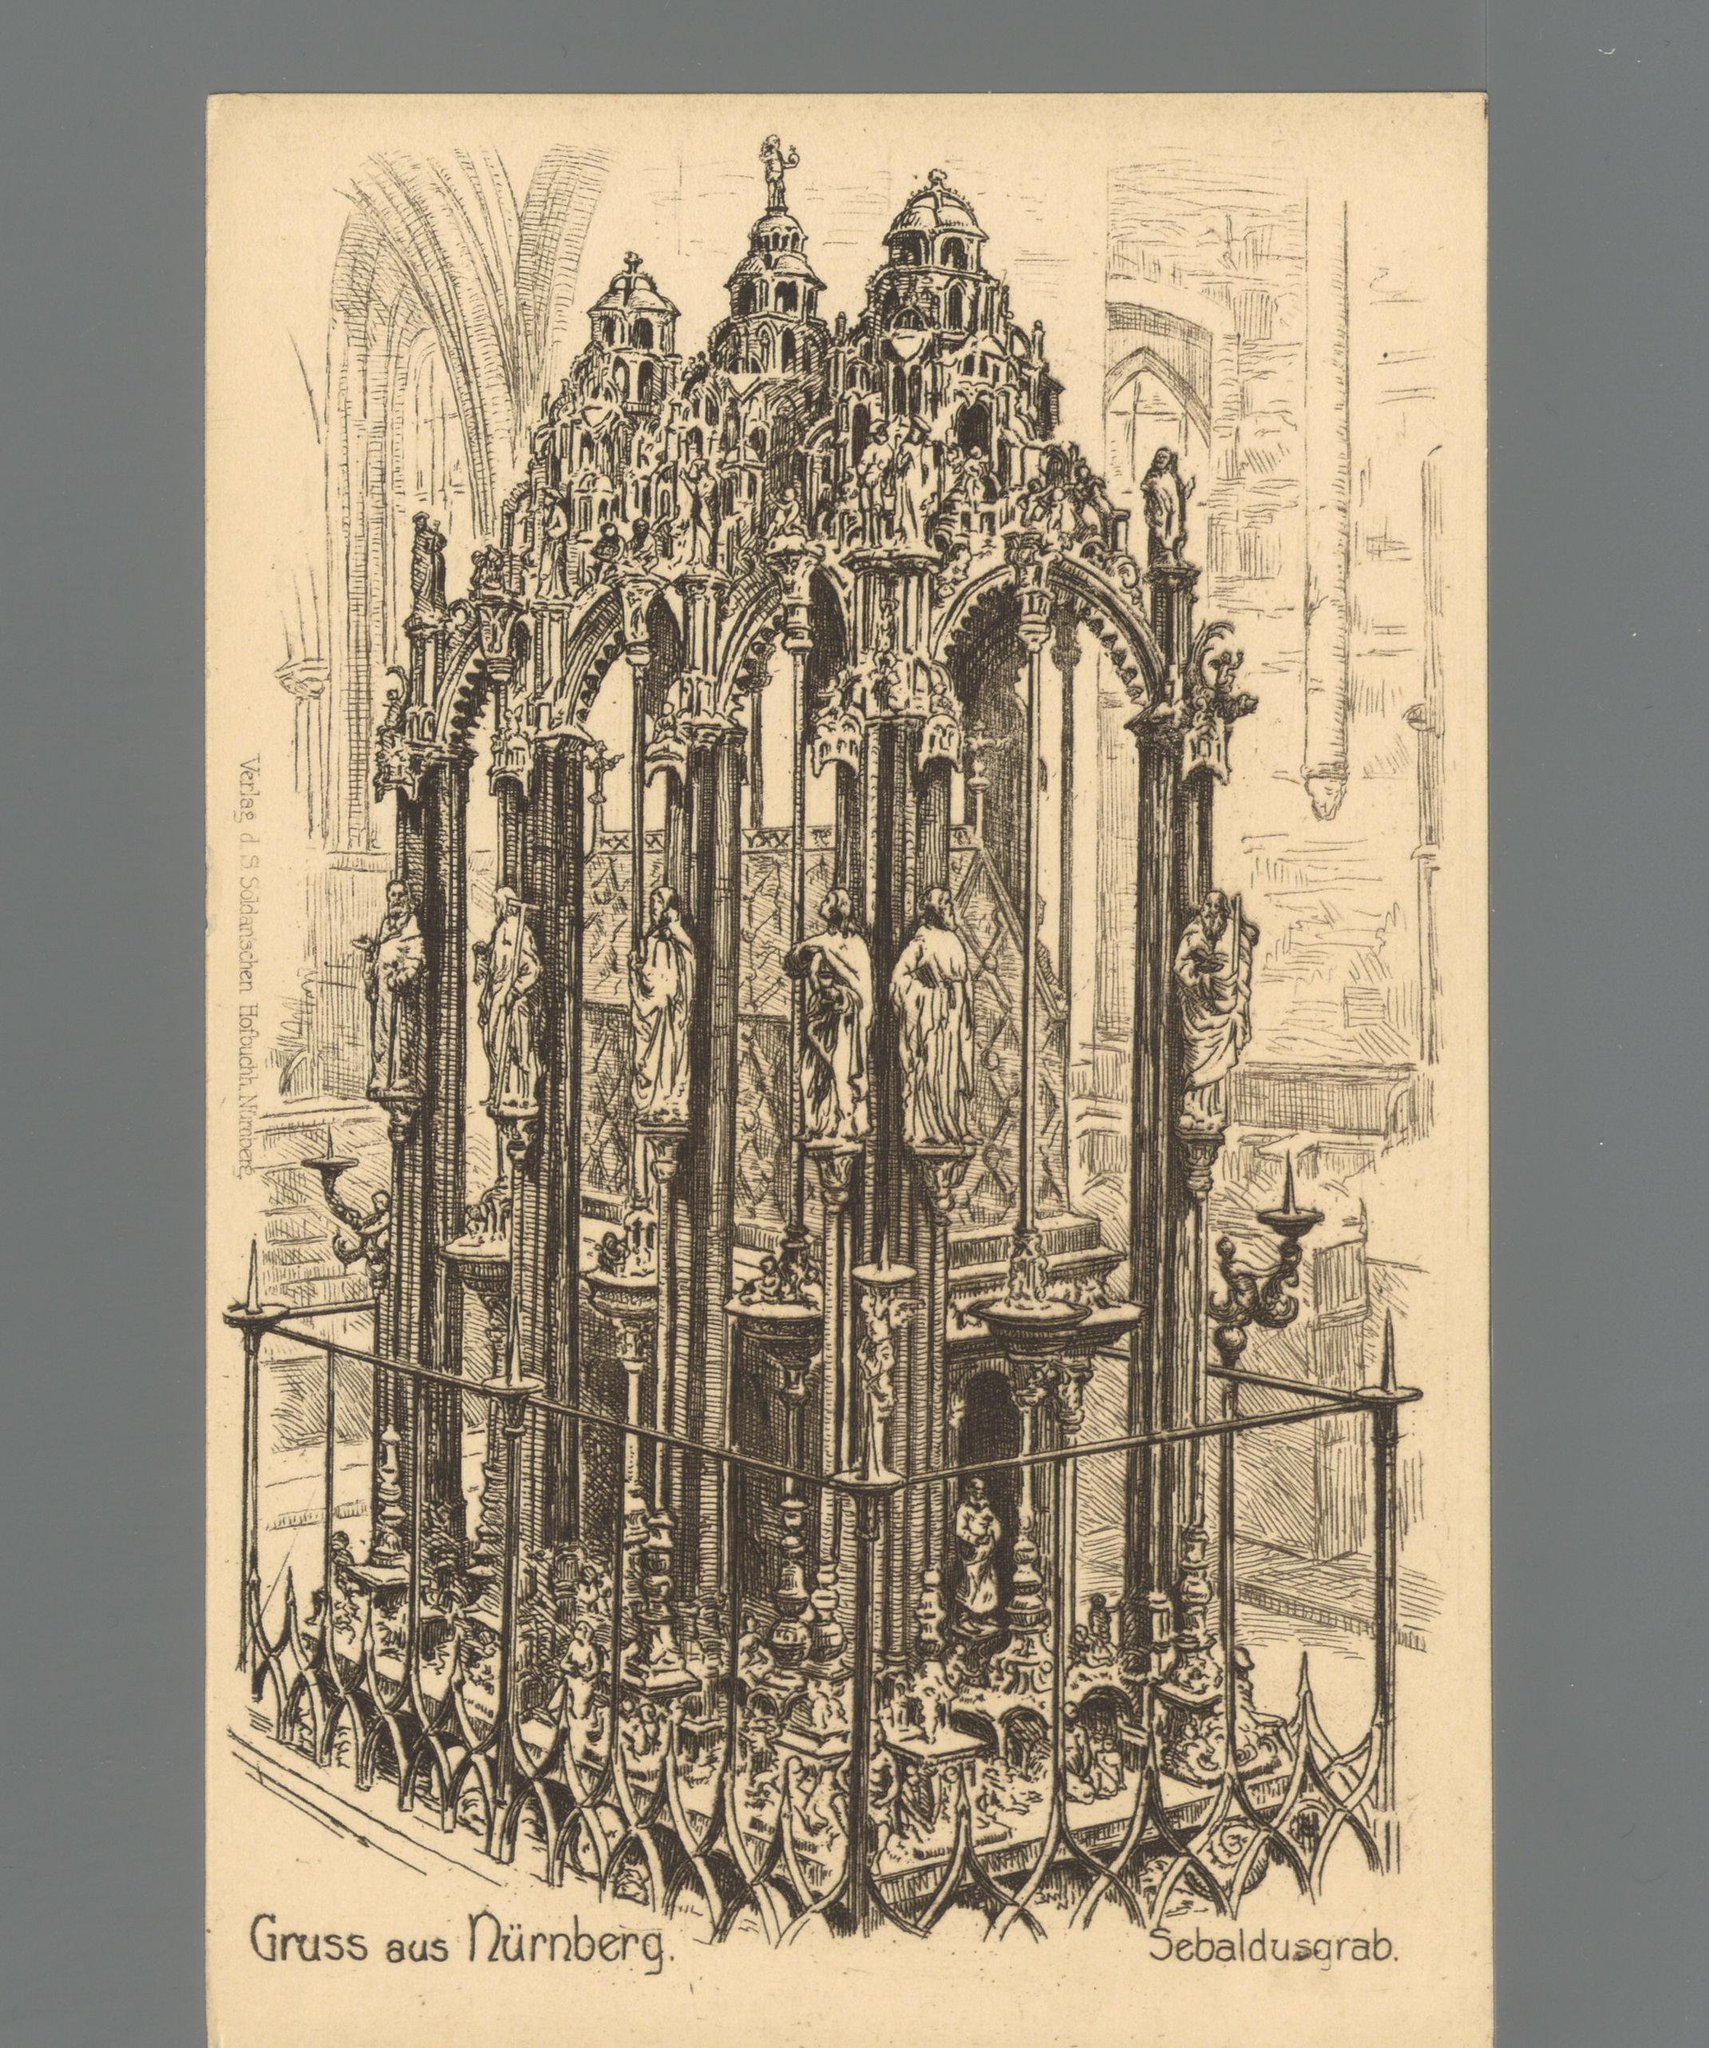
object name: ansichtkaart, prentbriefkaart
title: Gruss aus Nürnberg. Sebaldusgrab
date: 1905-1909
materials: cardboard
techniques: etching, writing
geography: nuremberg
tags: grave, tomb, interior of church